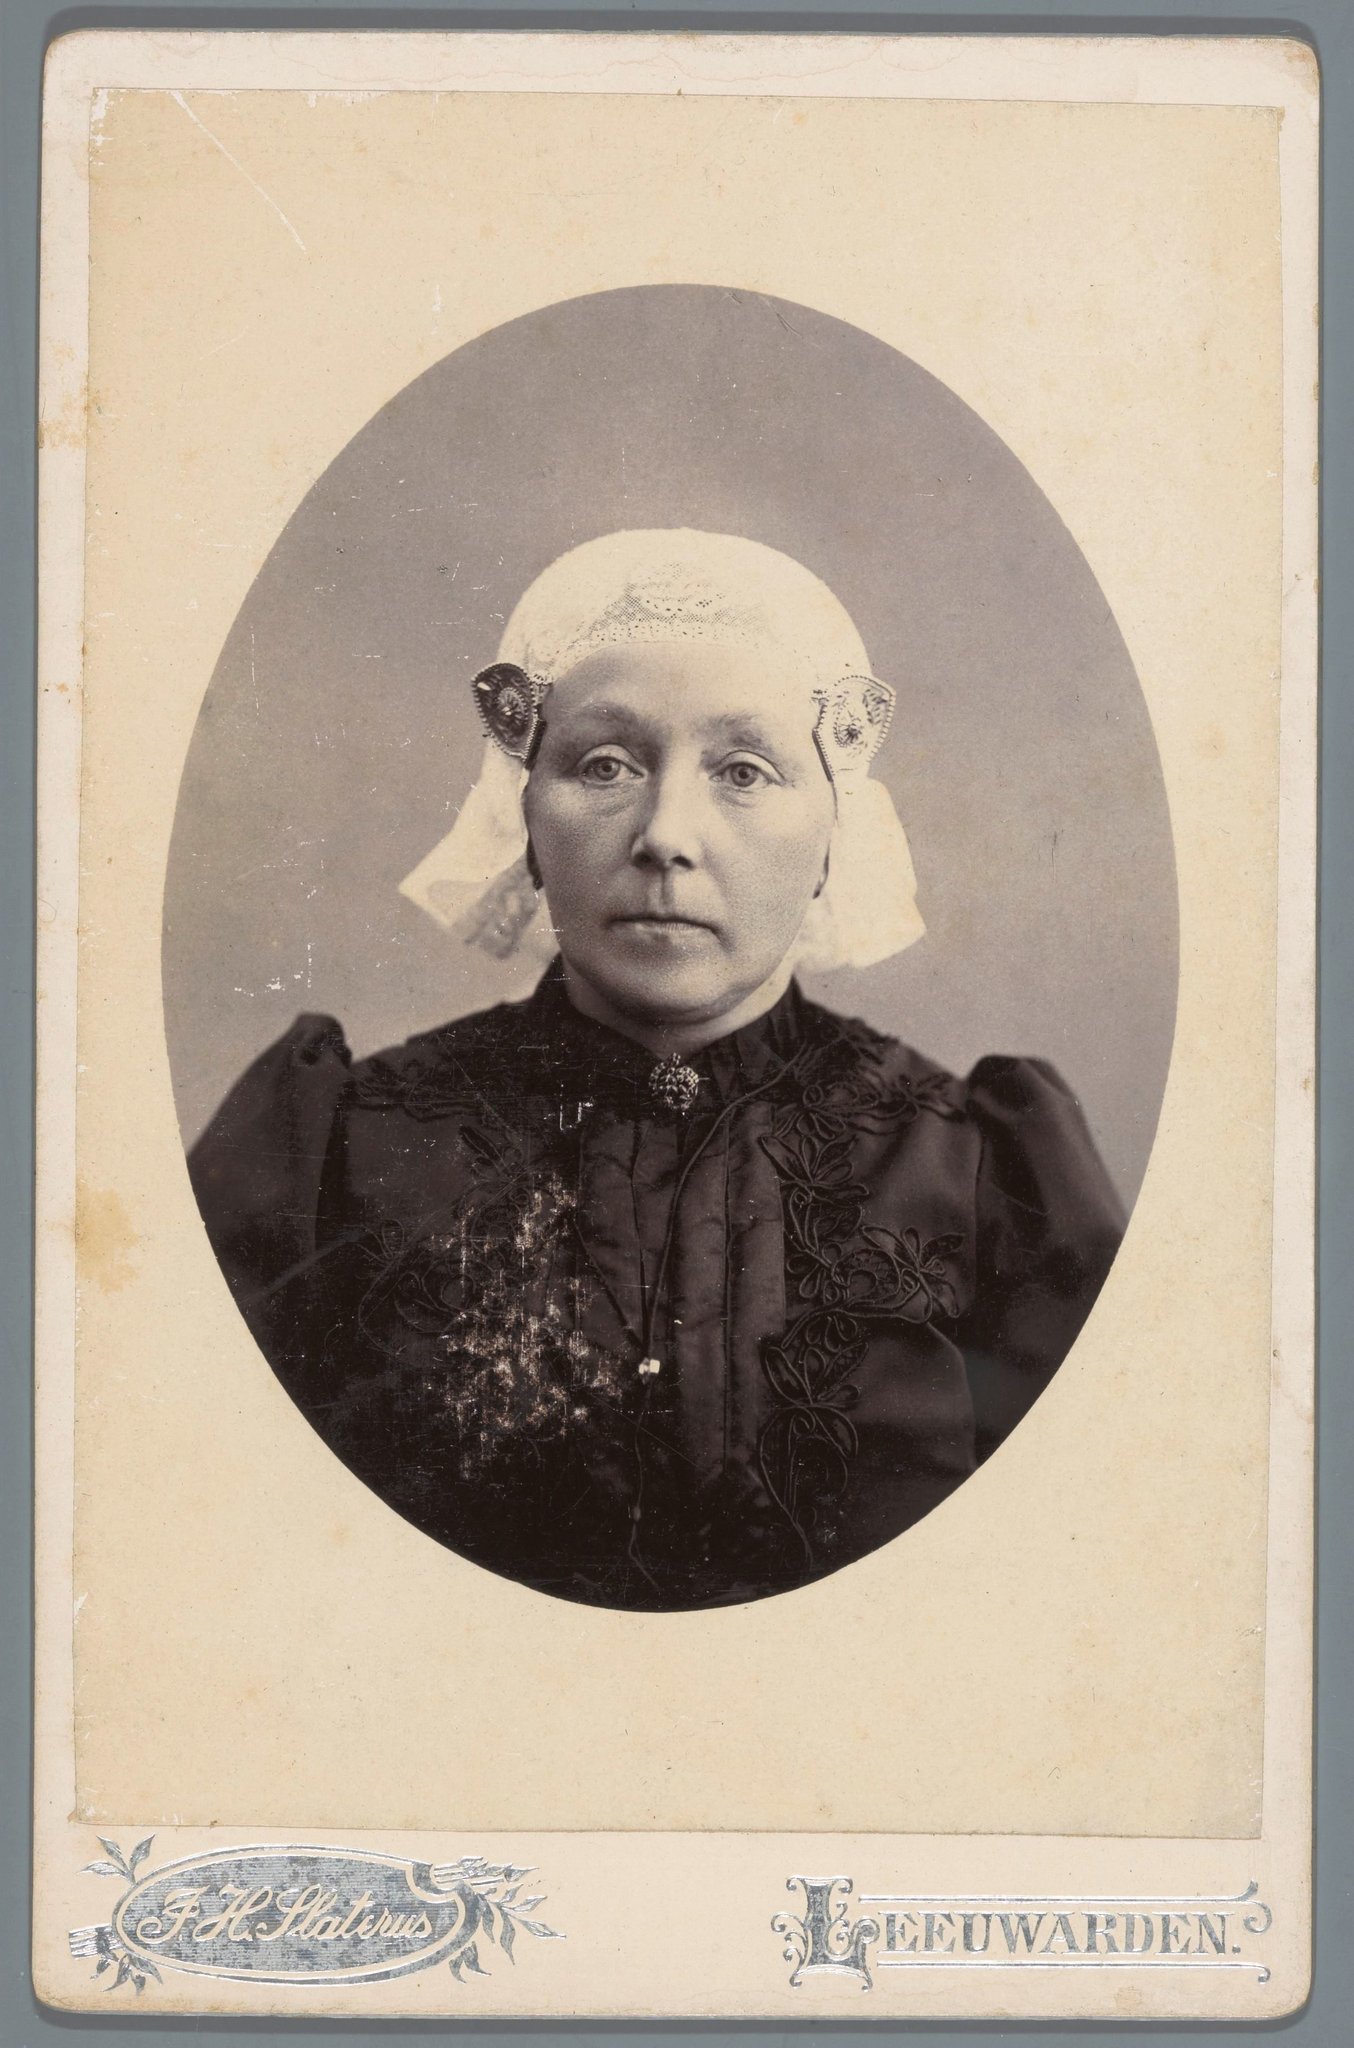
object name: cabinet photograph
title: Portret van een onbekende vrouw in Friese klederdracht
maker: idanus hendrikus slaterus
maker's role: fotograaf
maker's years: 1846-1921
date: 1890-1910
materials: cardboard, photographic support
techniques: collodion silver print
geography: leeuwarden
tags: adult woman, folk costume, regional costume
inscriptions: inscription: ‘Atelier I. H. Slaterus Leeuwarden Langemarkt-Straat Let. W. No. 14 tegen over het station bij de Nieuwe Veemarkt. Specialiteit in Vergrootingen’